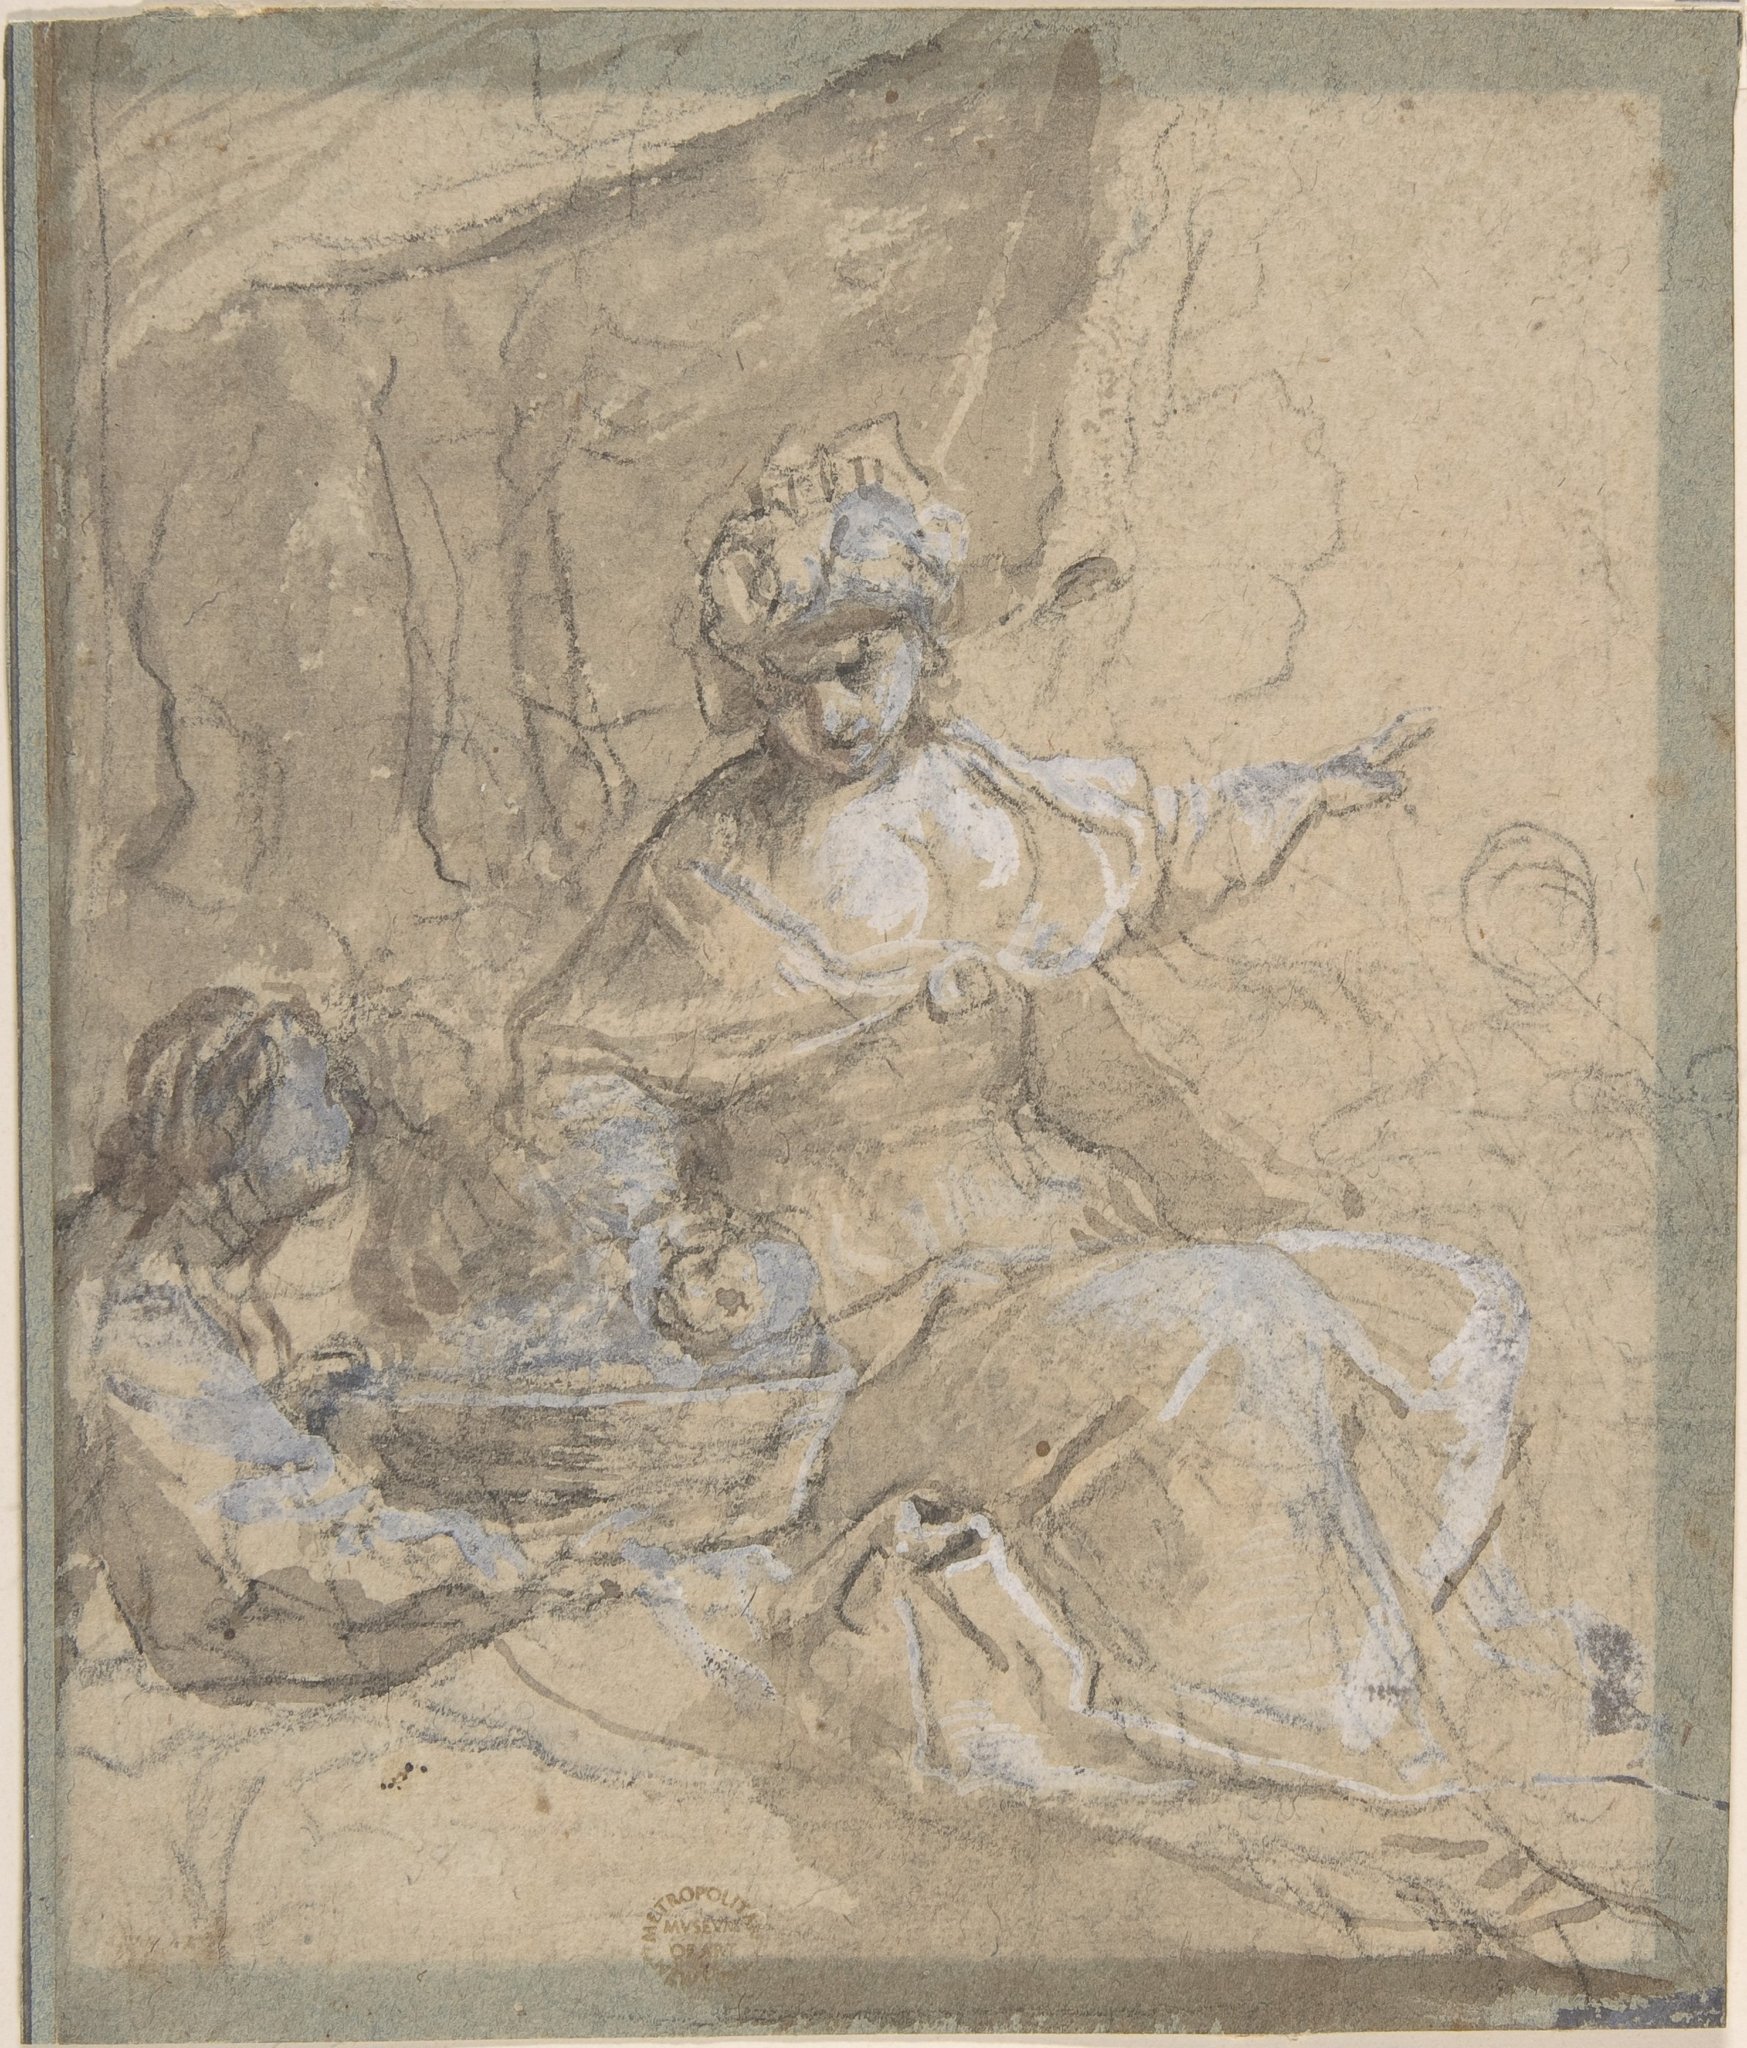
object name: drawing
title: The Finding of Moses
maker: anonymous, italian, roman-bolognese, 17th century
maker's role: artist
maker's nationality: italian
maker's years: 1600-1700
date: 1601-1700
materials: chalk, gouache, paper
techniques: brush, highlighting, wash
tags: women,moses